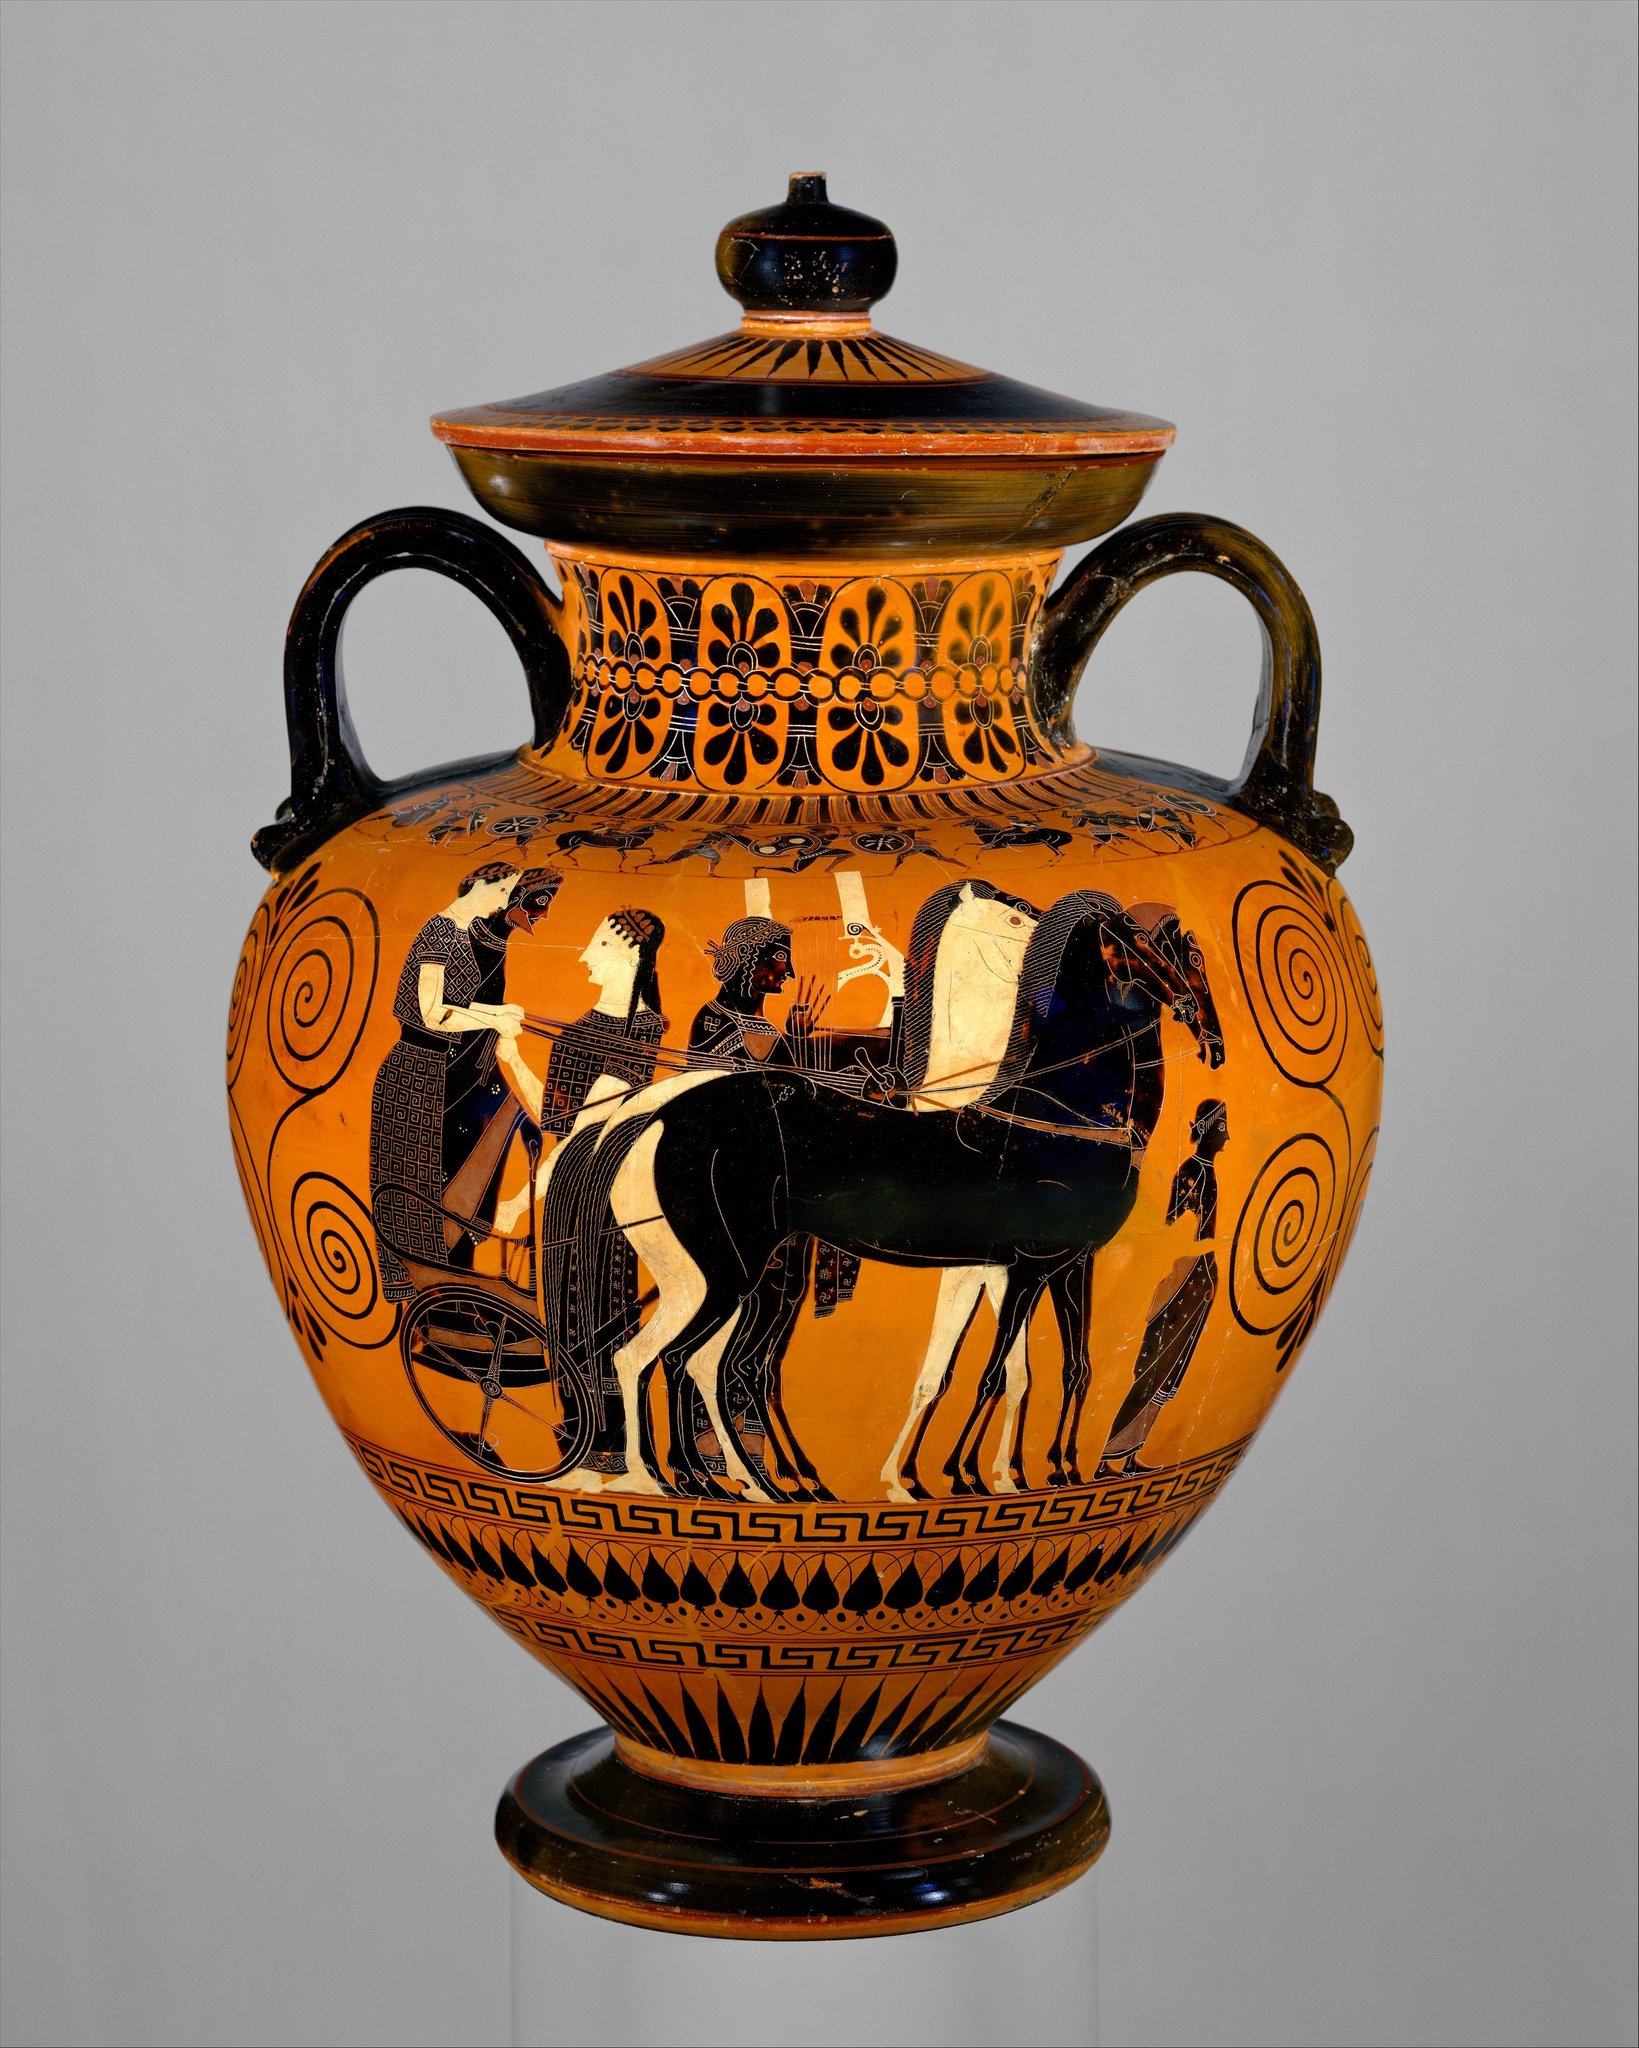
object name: knob of an amphora lid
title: Knob from the lid of a neck-amphora, joins lid of 17.230.14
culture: greek, attic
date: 540 BCE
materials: terracotta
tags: men,women,horses,chariots